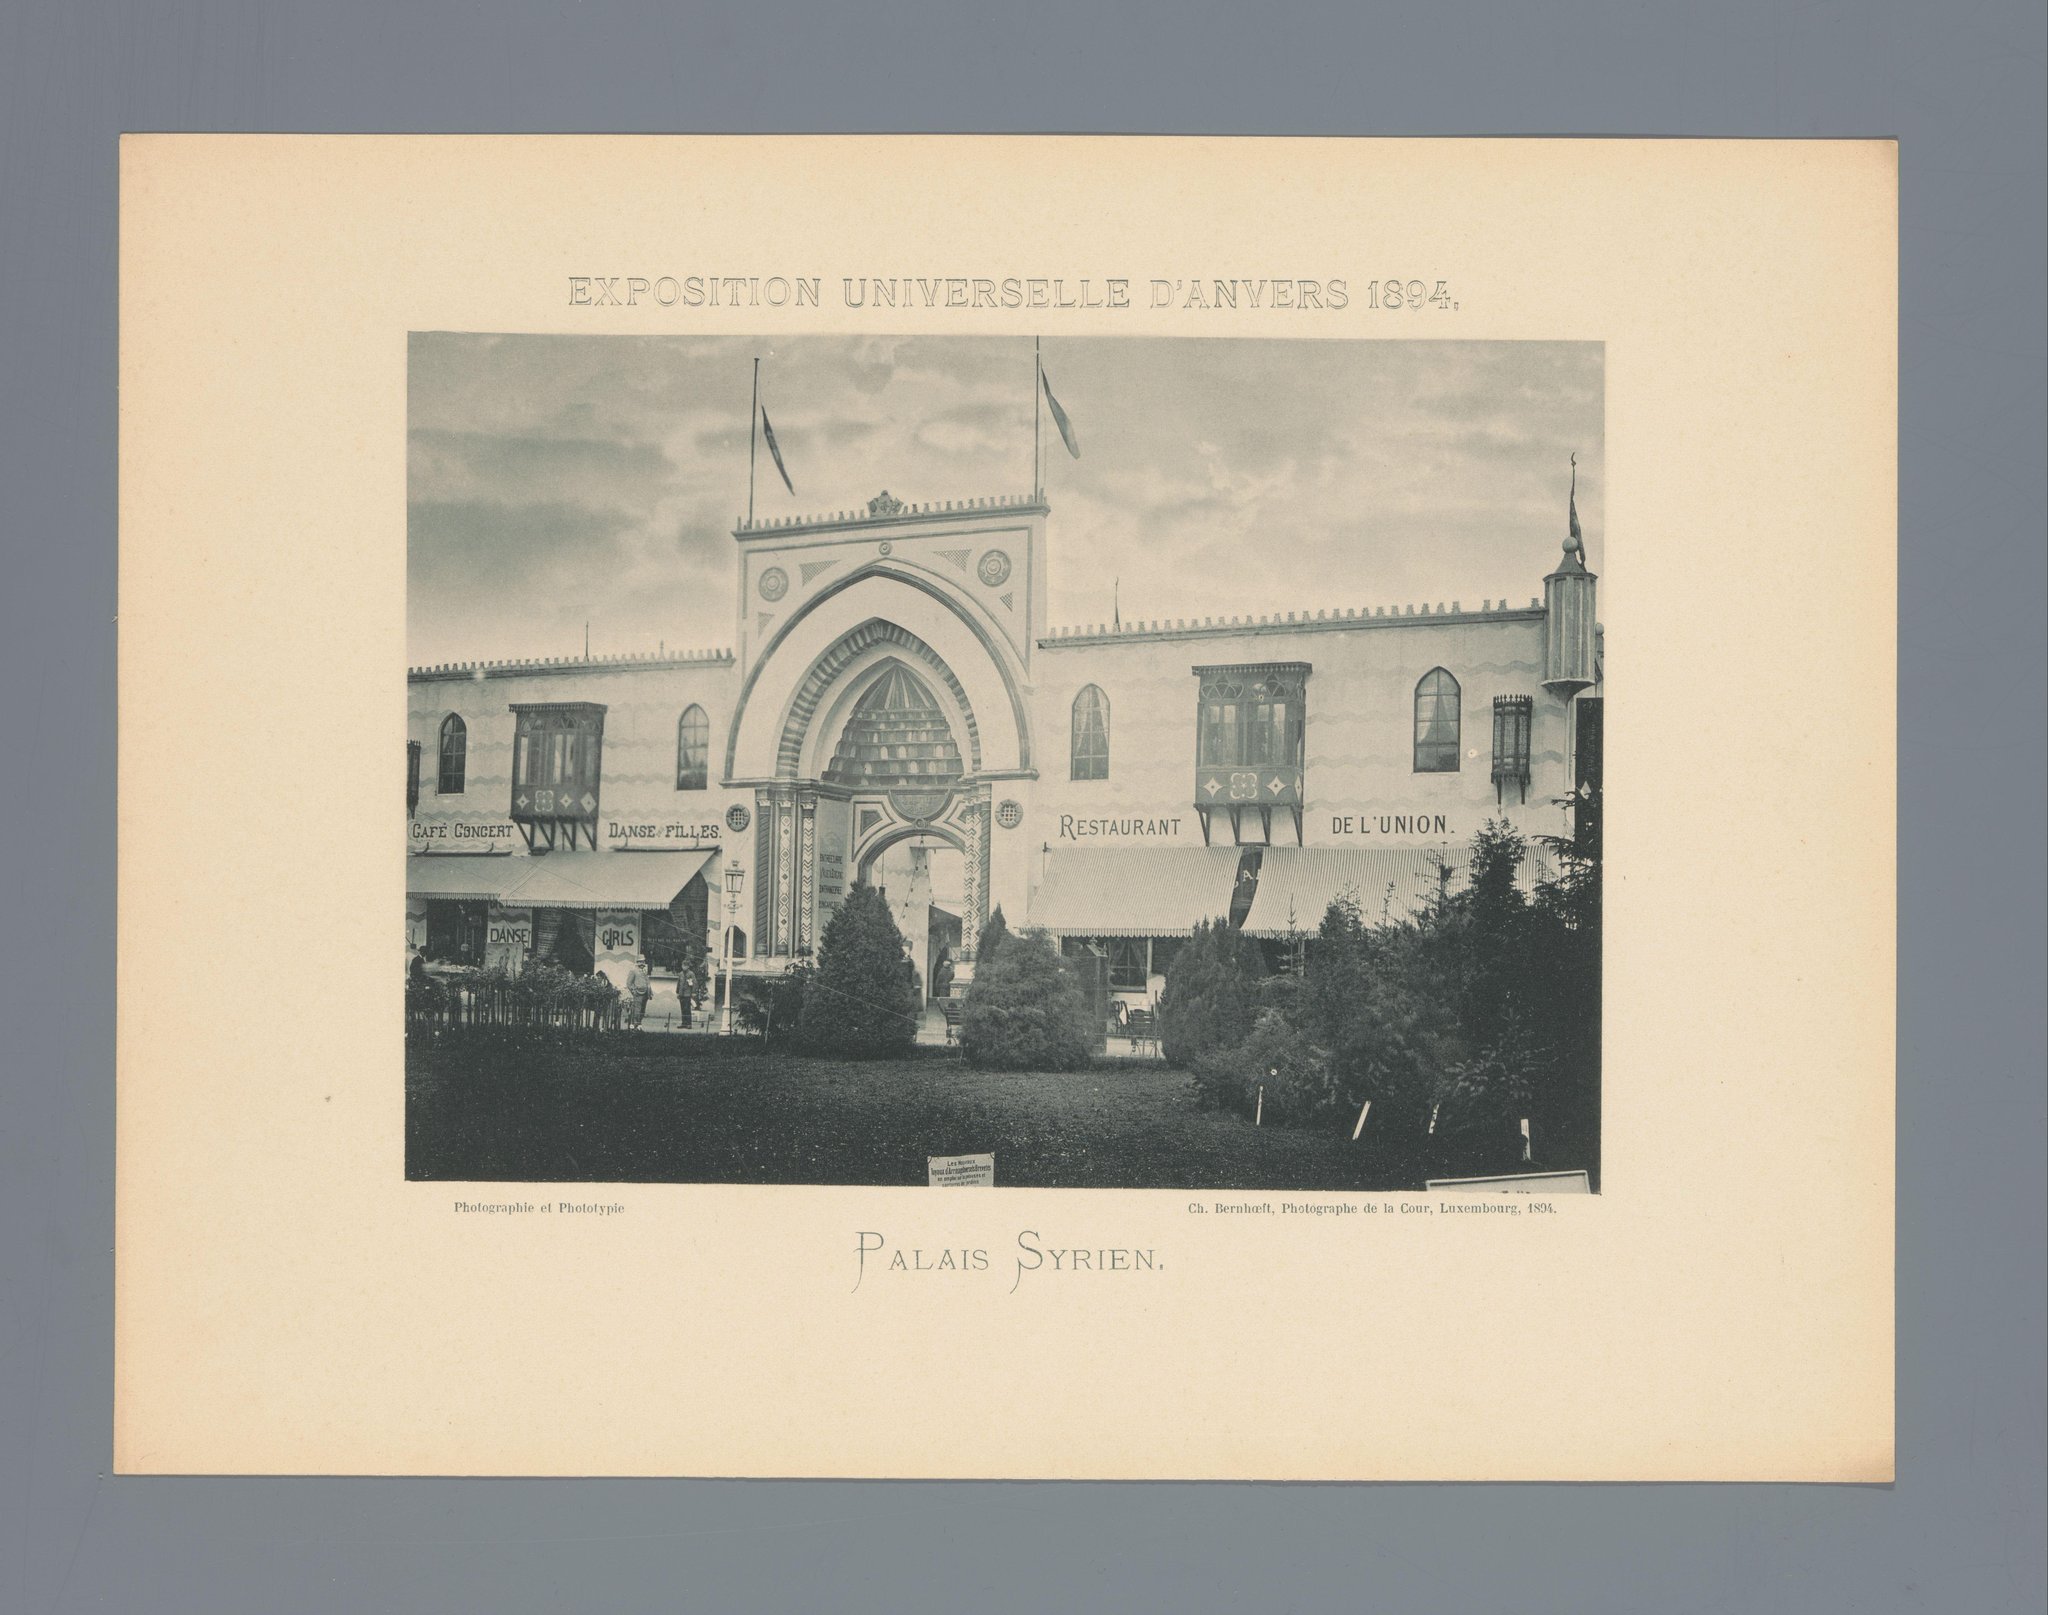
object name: photomechanical print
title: Palais Syrien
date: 1894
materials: paper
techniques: photograph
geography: luxembourg city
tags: world fair, world exhibition, civic architecture; edifices; dwellings, antwerp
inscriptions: inscription: ‘Exposition Universelle D'Anvers 1894’